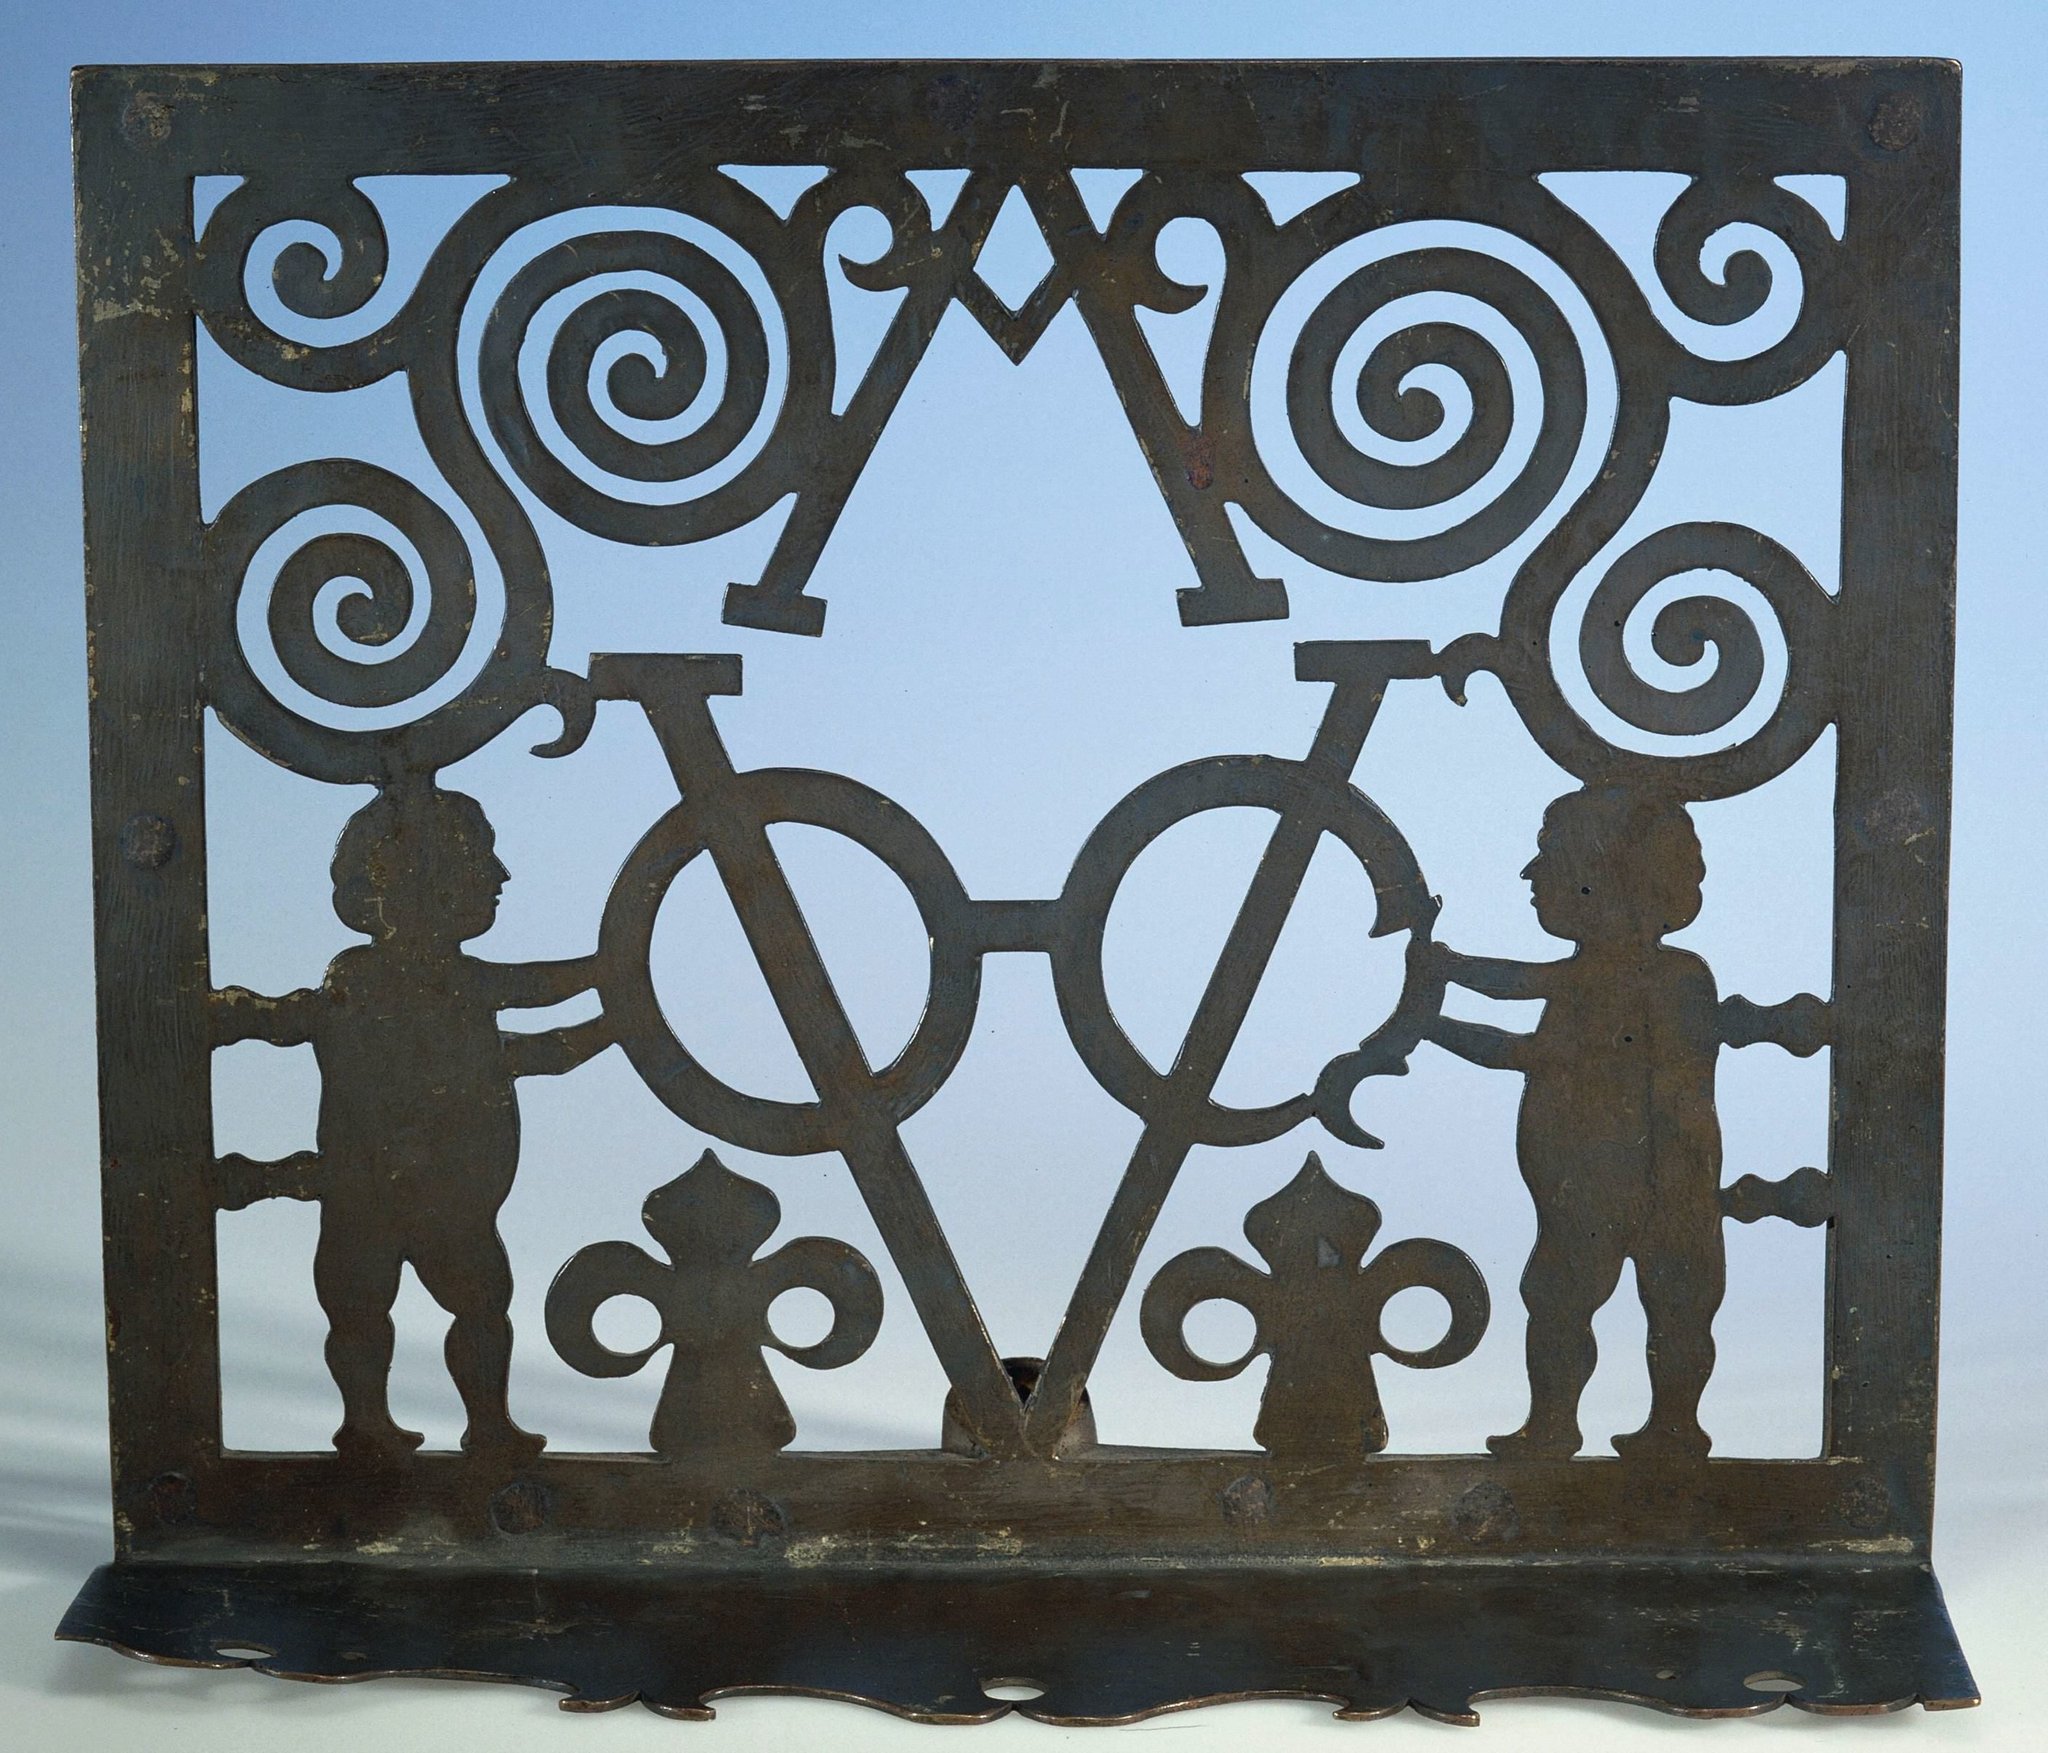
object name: standaard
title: Standaard horend bij een lessenaar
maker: Anonymous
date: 1700-1800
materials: iron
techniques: forging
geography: amsterdam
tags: amsterdam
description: IJzeren standaard horend bij een lessenaar.